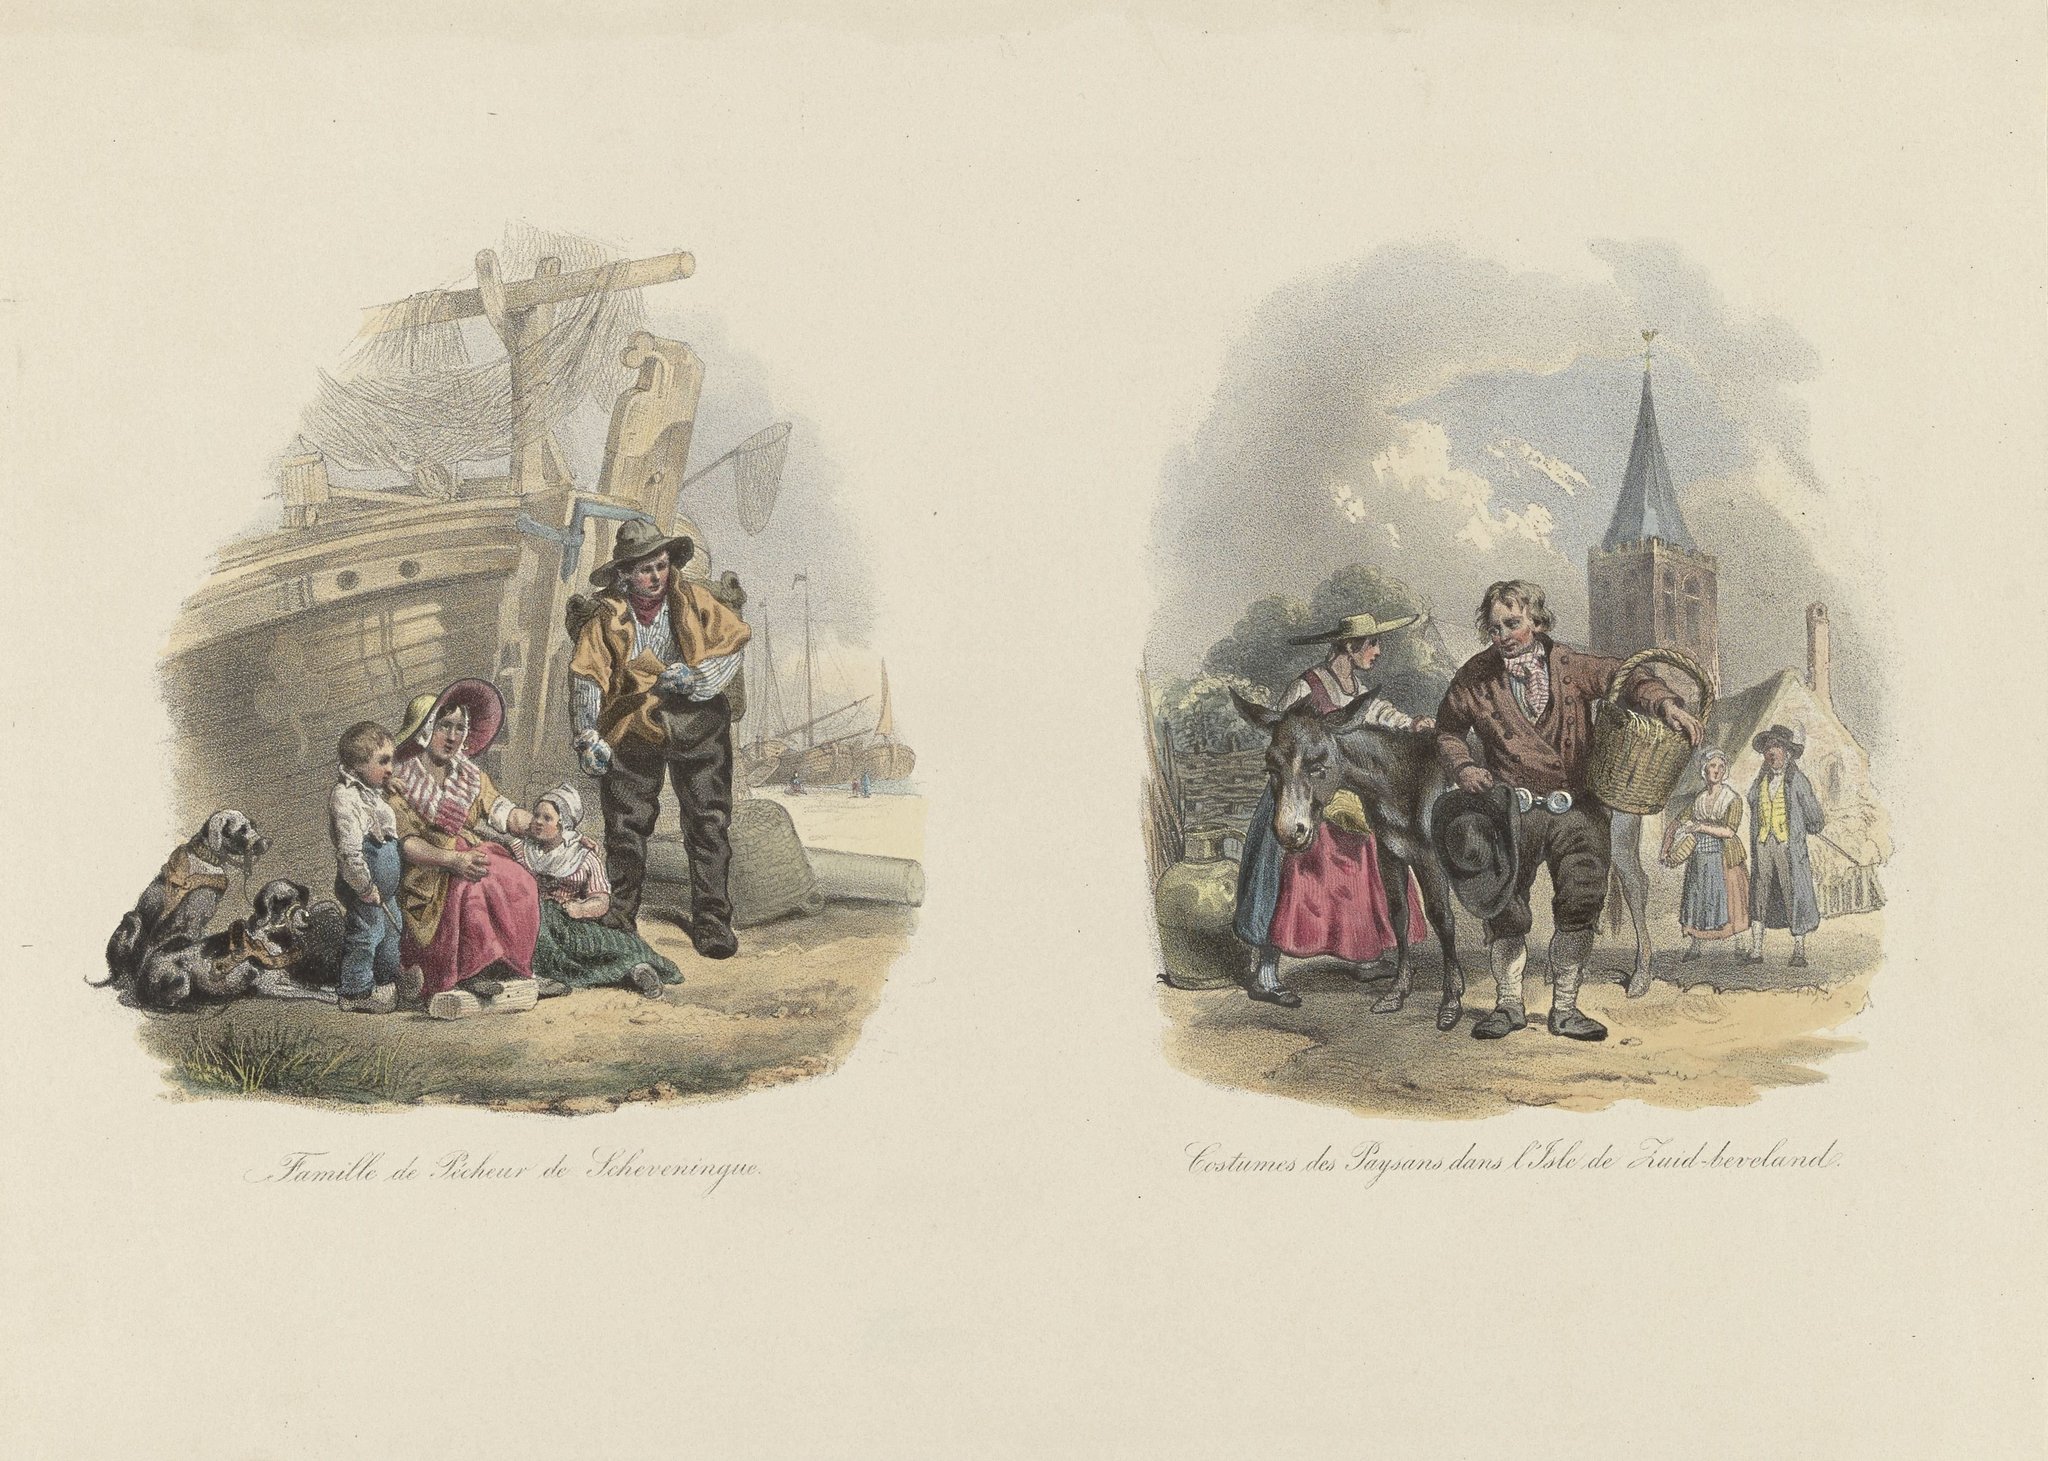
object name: print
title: Famille de Pécheur de Scheveningen / Costumes des Paysans dans l'Isle de Zuid-beveland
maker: Anonymous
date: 1840-1870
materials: paper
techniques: hand coloring, lacquer, lithograph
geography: netherlands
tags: folk costume, regional costume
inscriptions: collector's mark: Lugt 2228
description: Vissersgezin uit Scheveningen en boeren van Zuid-Beveland. Onderdeel van een serie van vier bladen met elk twee voorstellingen van Nederlandse regionale en lokale klederdrachten, ca. 1850.